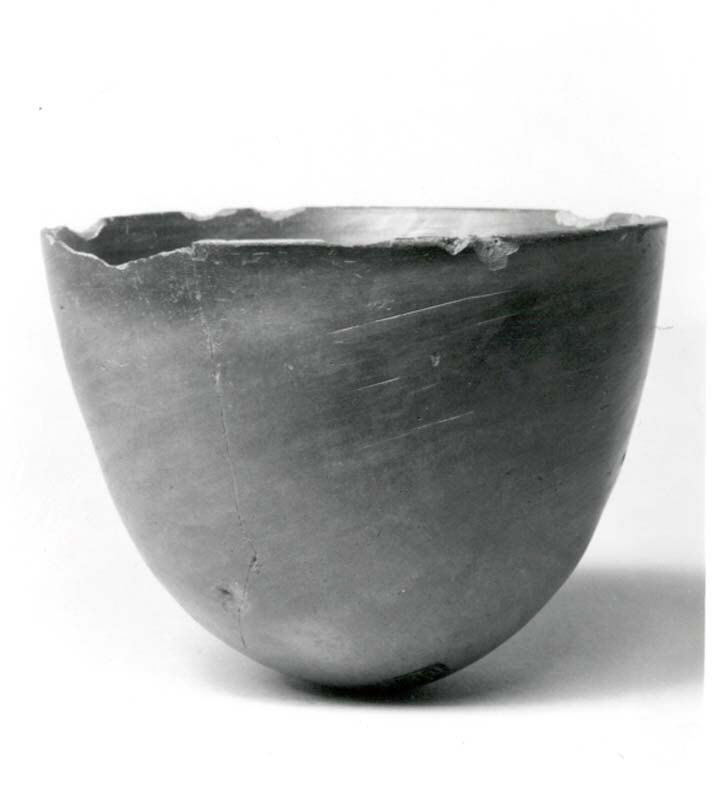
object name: cup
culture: iranian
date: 3000-2001 BCE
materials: ceramic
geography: iran